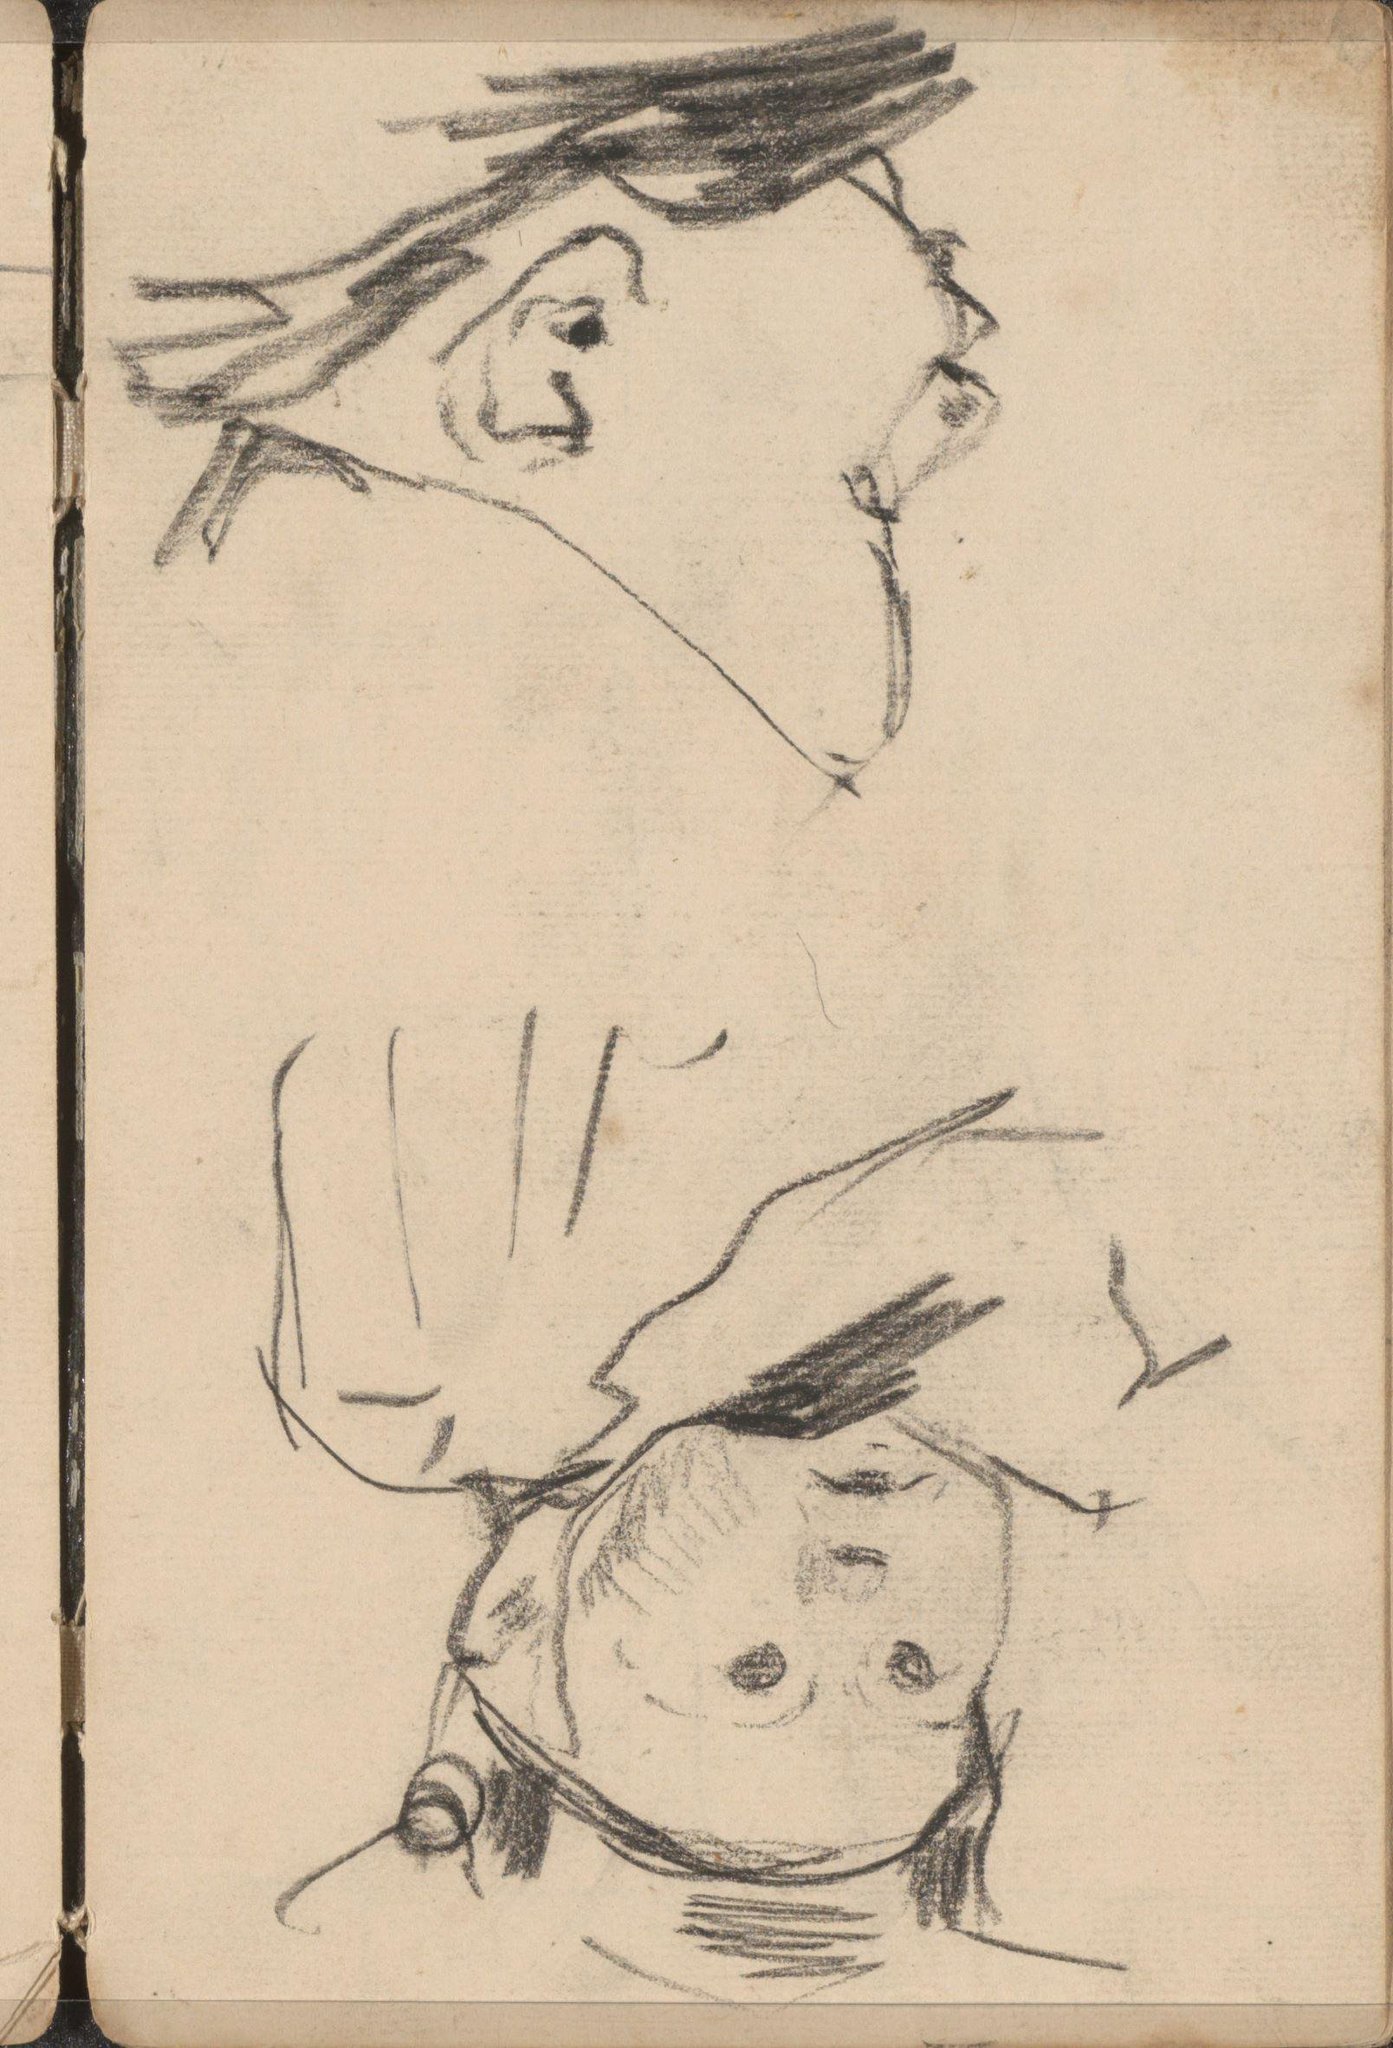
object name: sketchbook leaf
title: Twee studies van een jong kind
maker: george hendrik breitner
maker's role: draughtsman, painter, print maker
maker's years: 1857-1923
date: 1886-1923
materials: chalk, paper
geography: amsterdam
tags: child, amsterdam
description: Pagina 14 uit een schetsboek met 14 bladen.